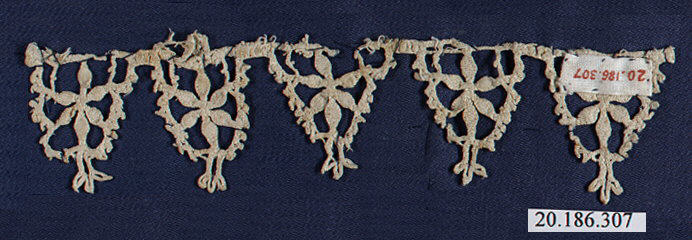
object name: edging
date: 1501-1600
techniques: lace